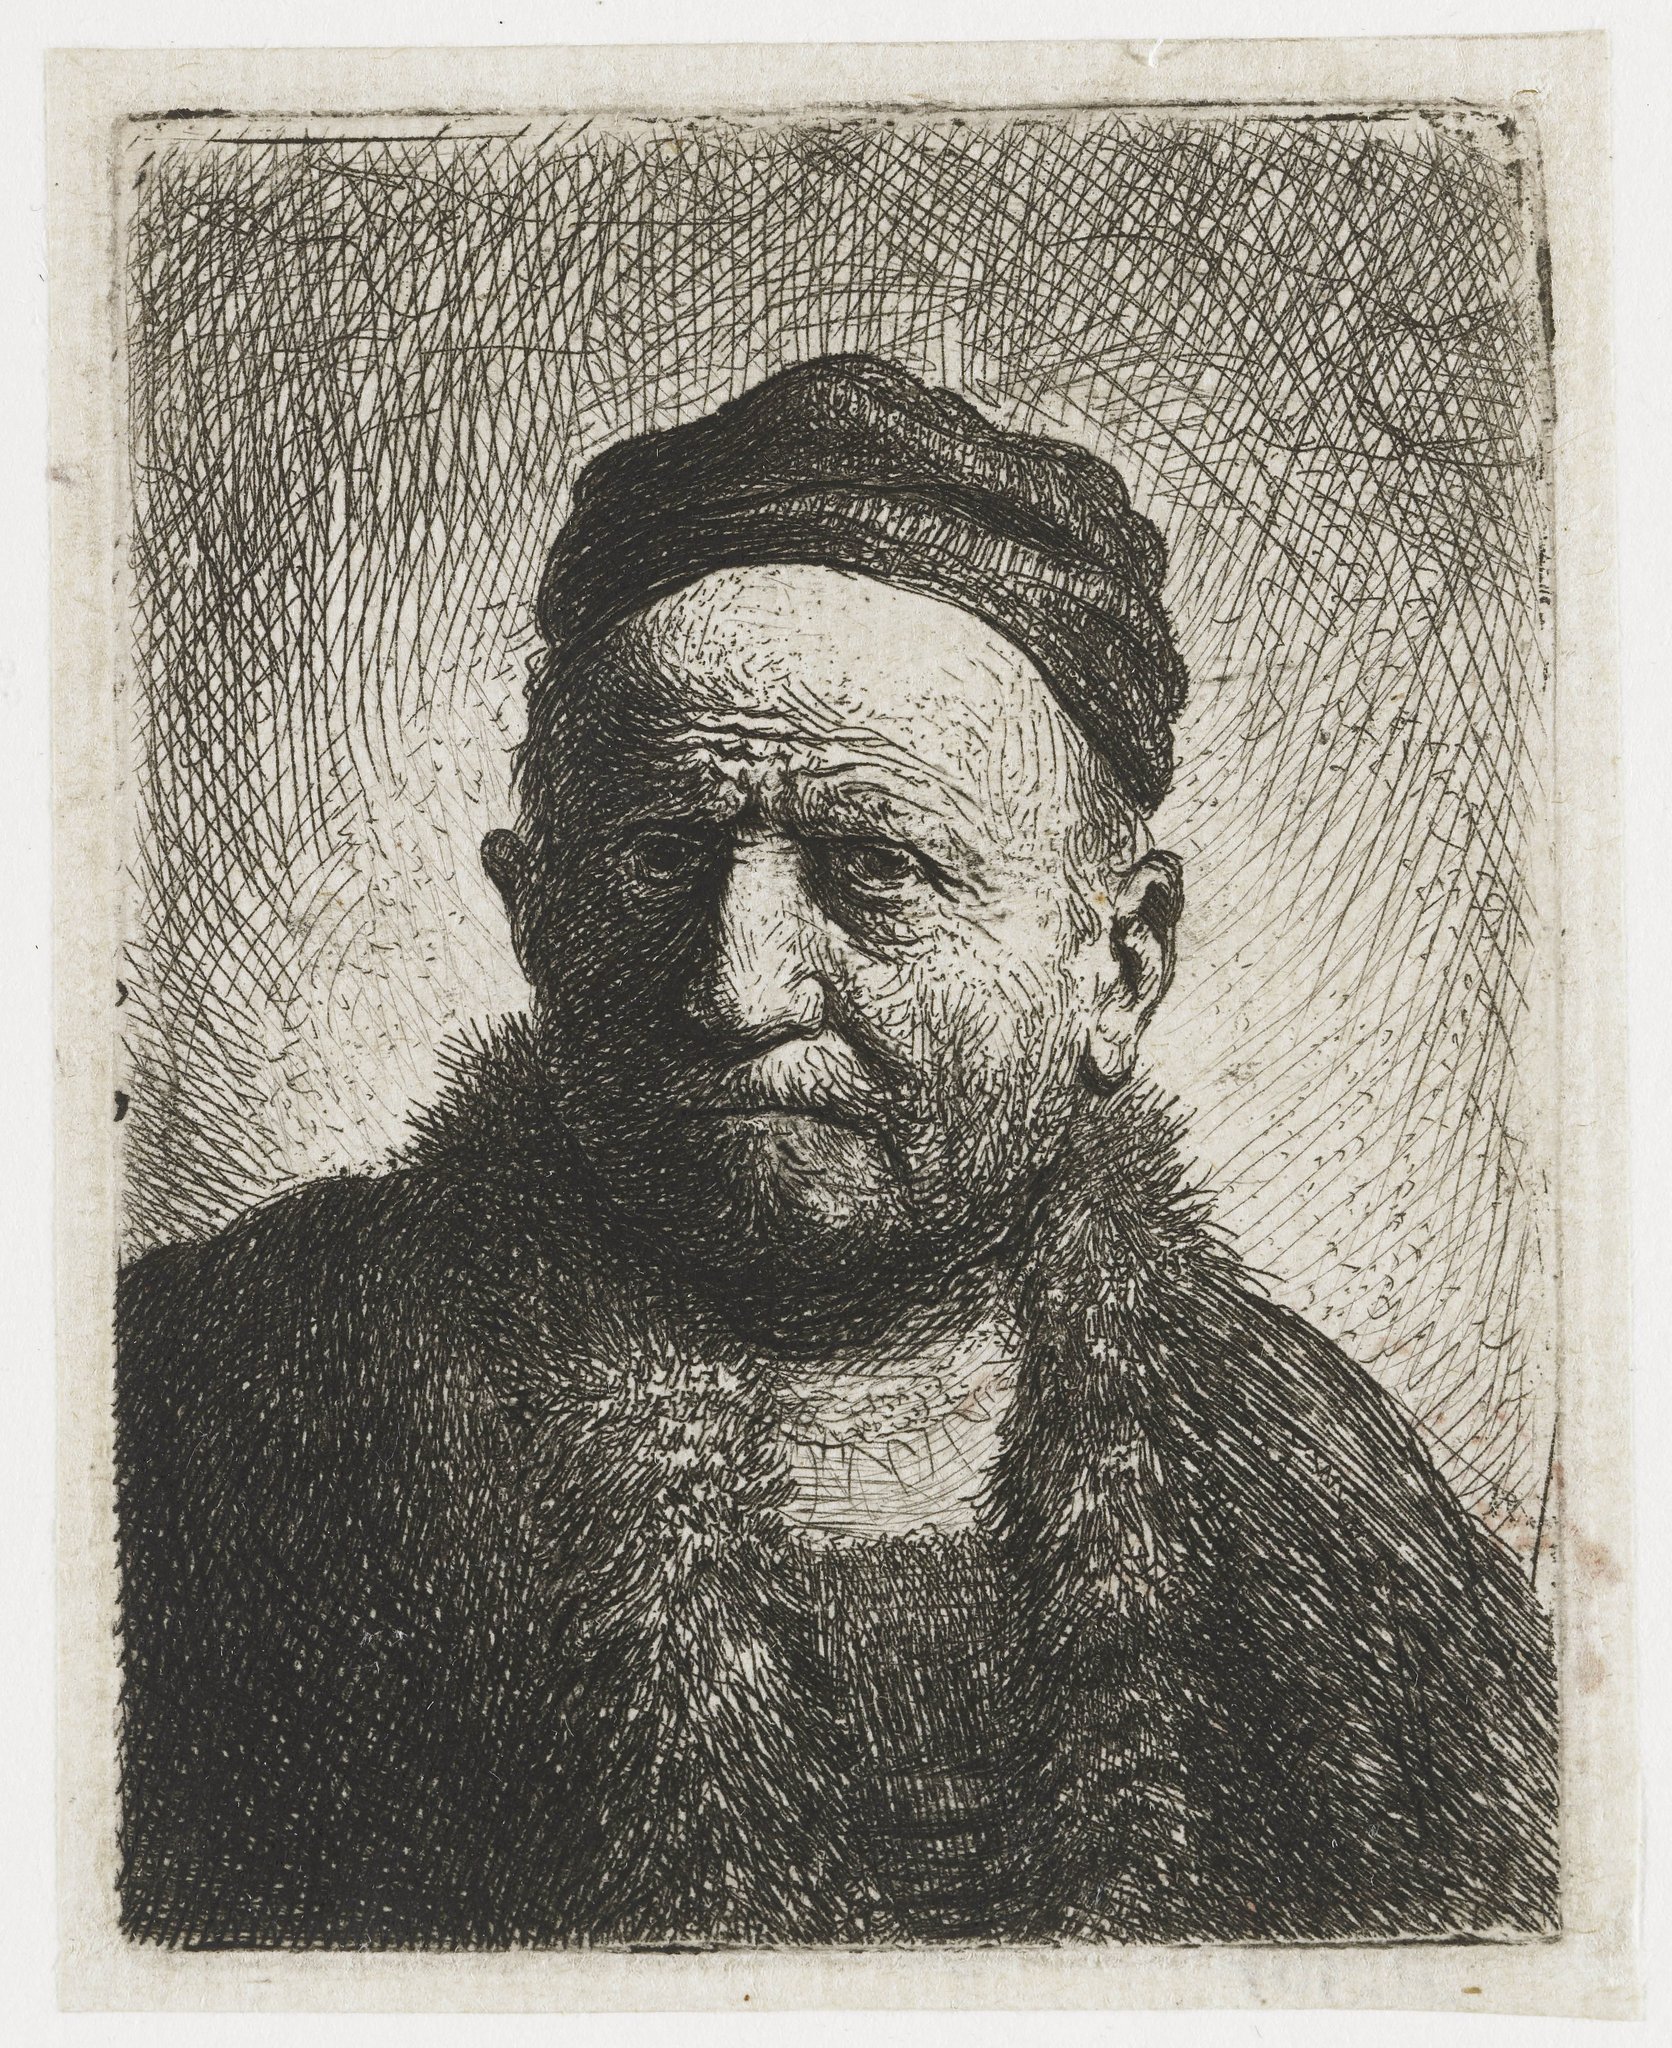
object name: print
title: Man wearing a close cap: bust (the artist's father?)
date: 1630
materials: paper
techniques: etching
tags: leiden, can hook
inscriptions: collector's mark: Lugt 240, monogram and date: ‘RHL 1630’